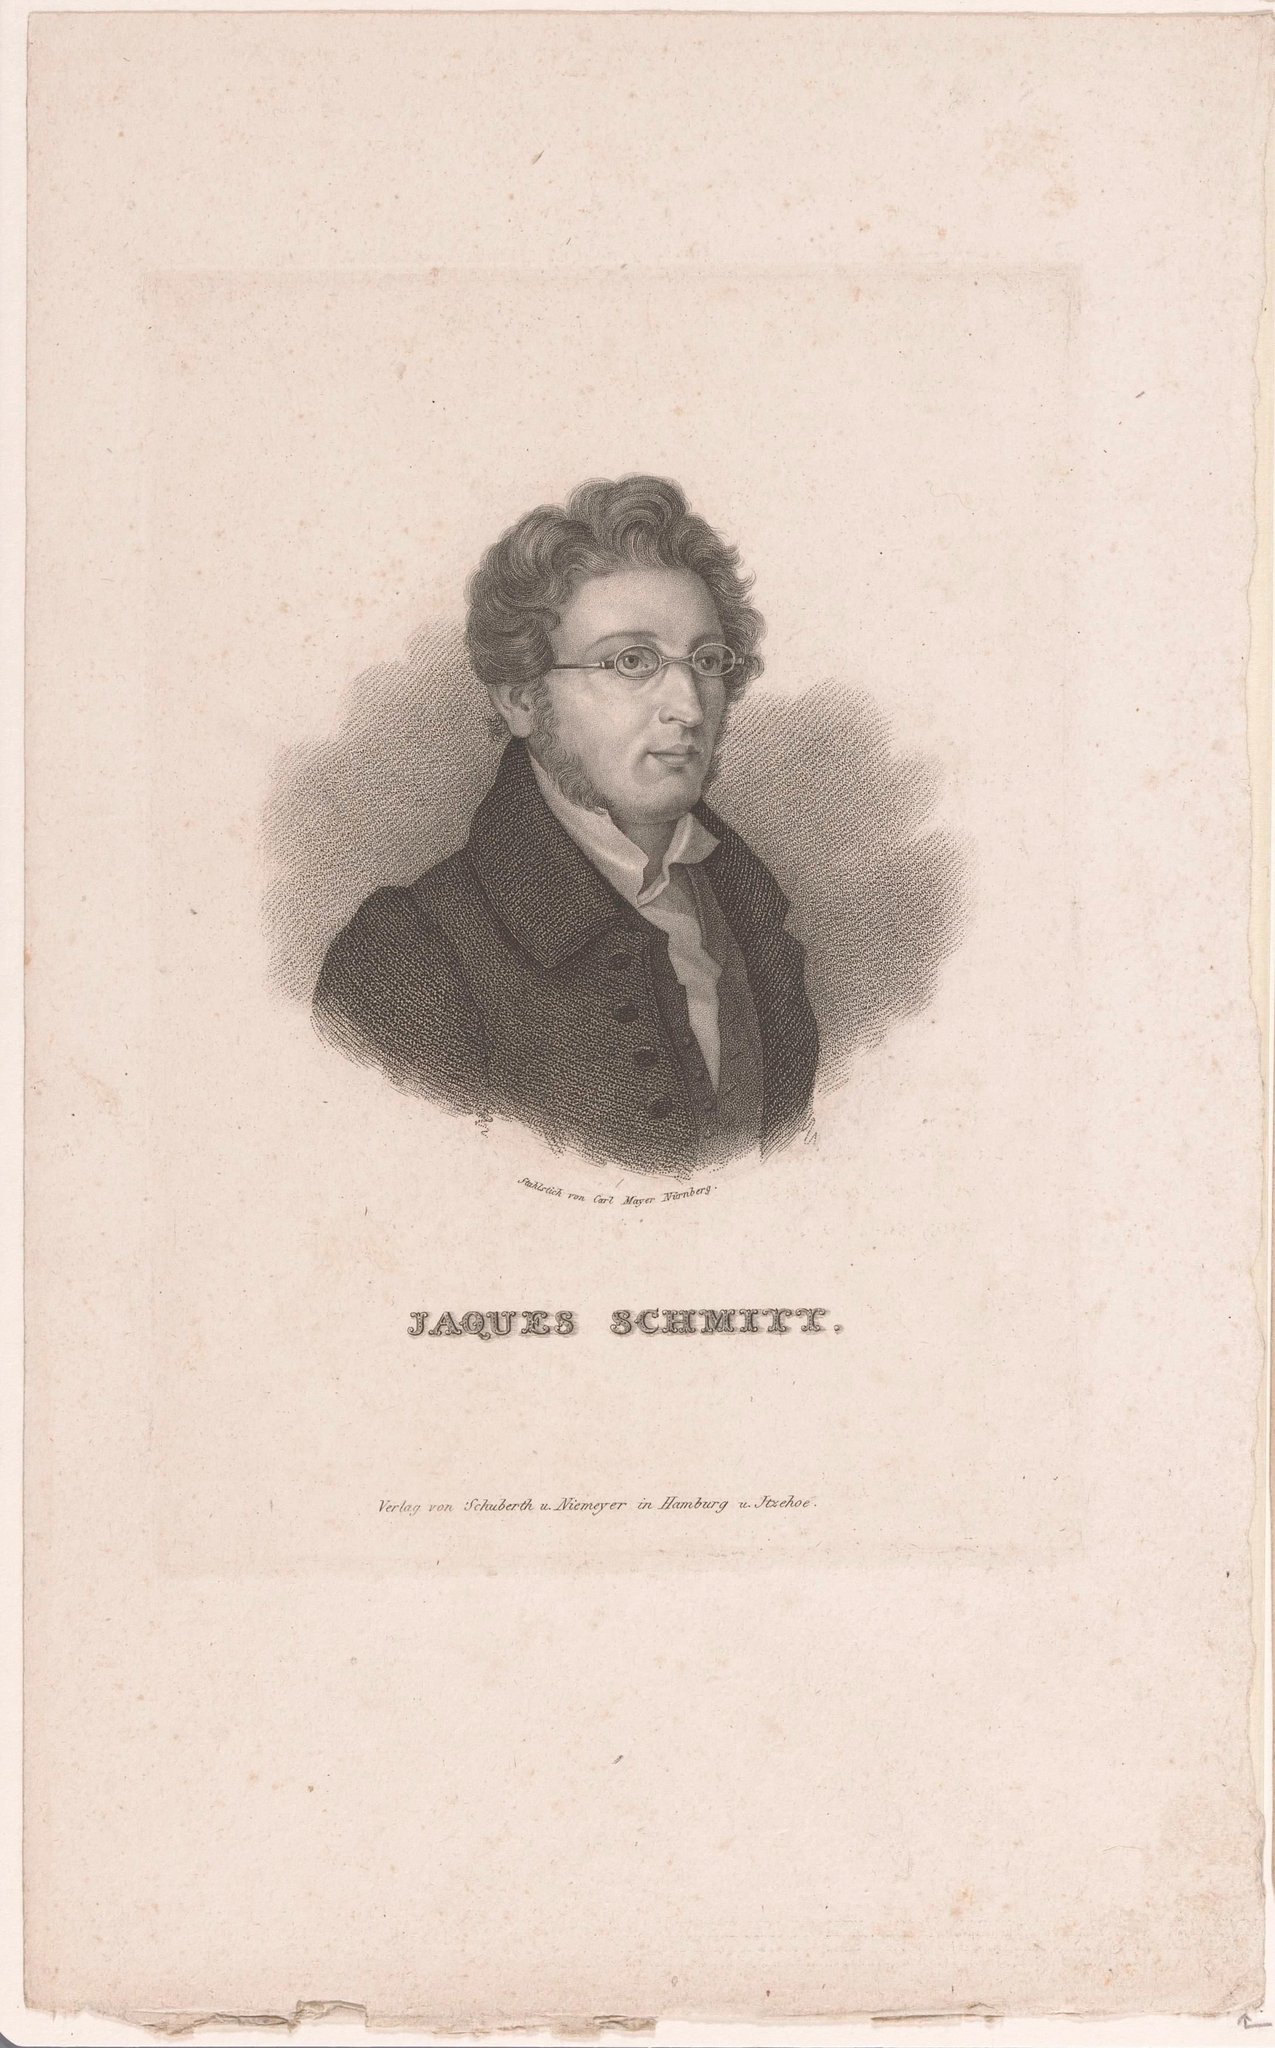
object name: print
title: Portret van Jacob Schmitt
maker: carl mayer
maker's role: print maker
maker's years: 1798-1868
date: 1829-1839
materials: paper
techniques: engraving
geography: hamburg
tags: historical persons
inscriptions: collector's mark: Lugt 2228